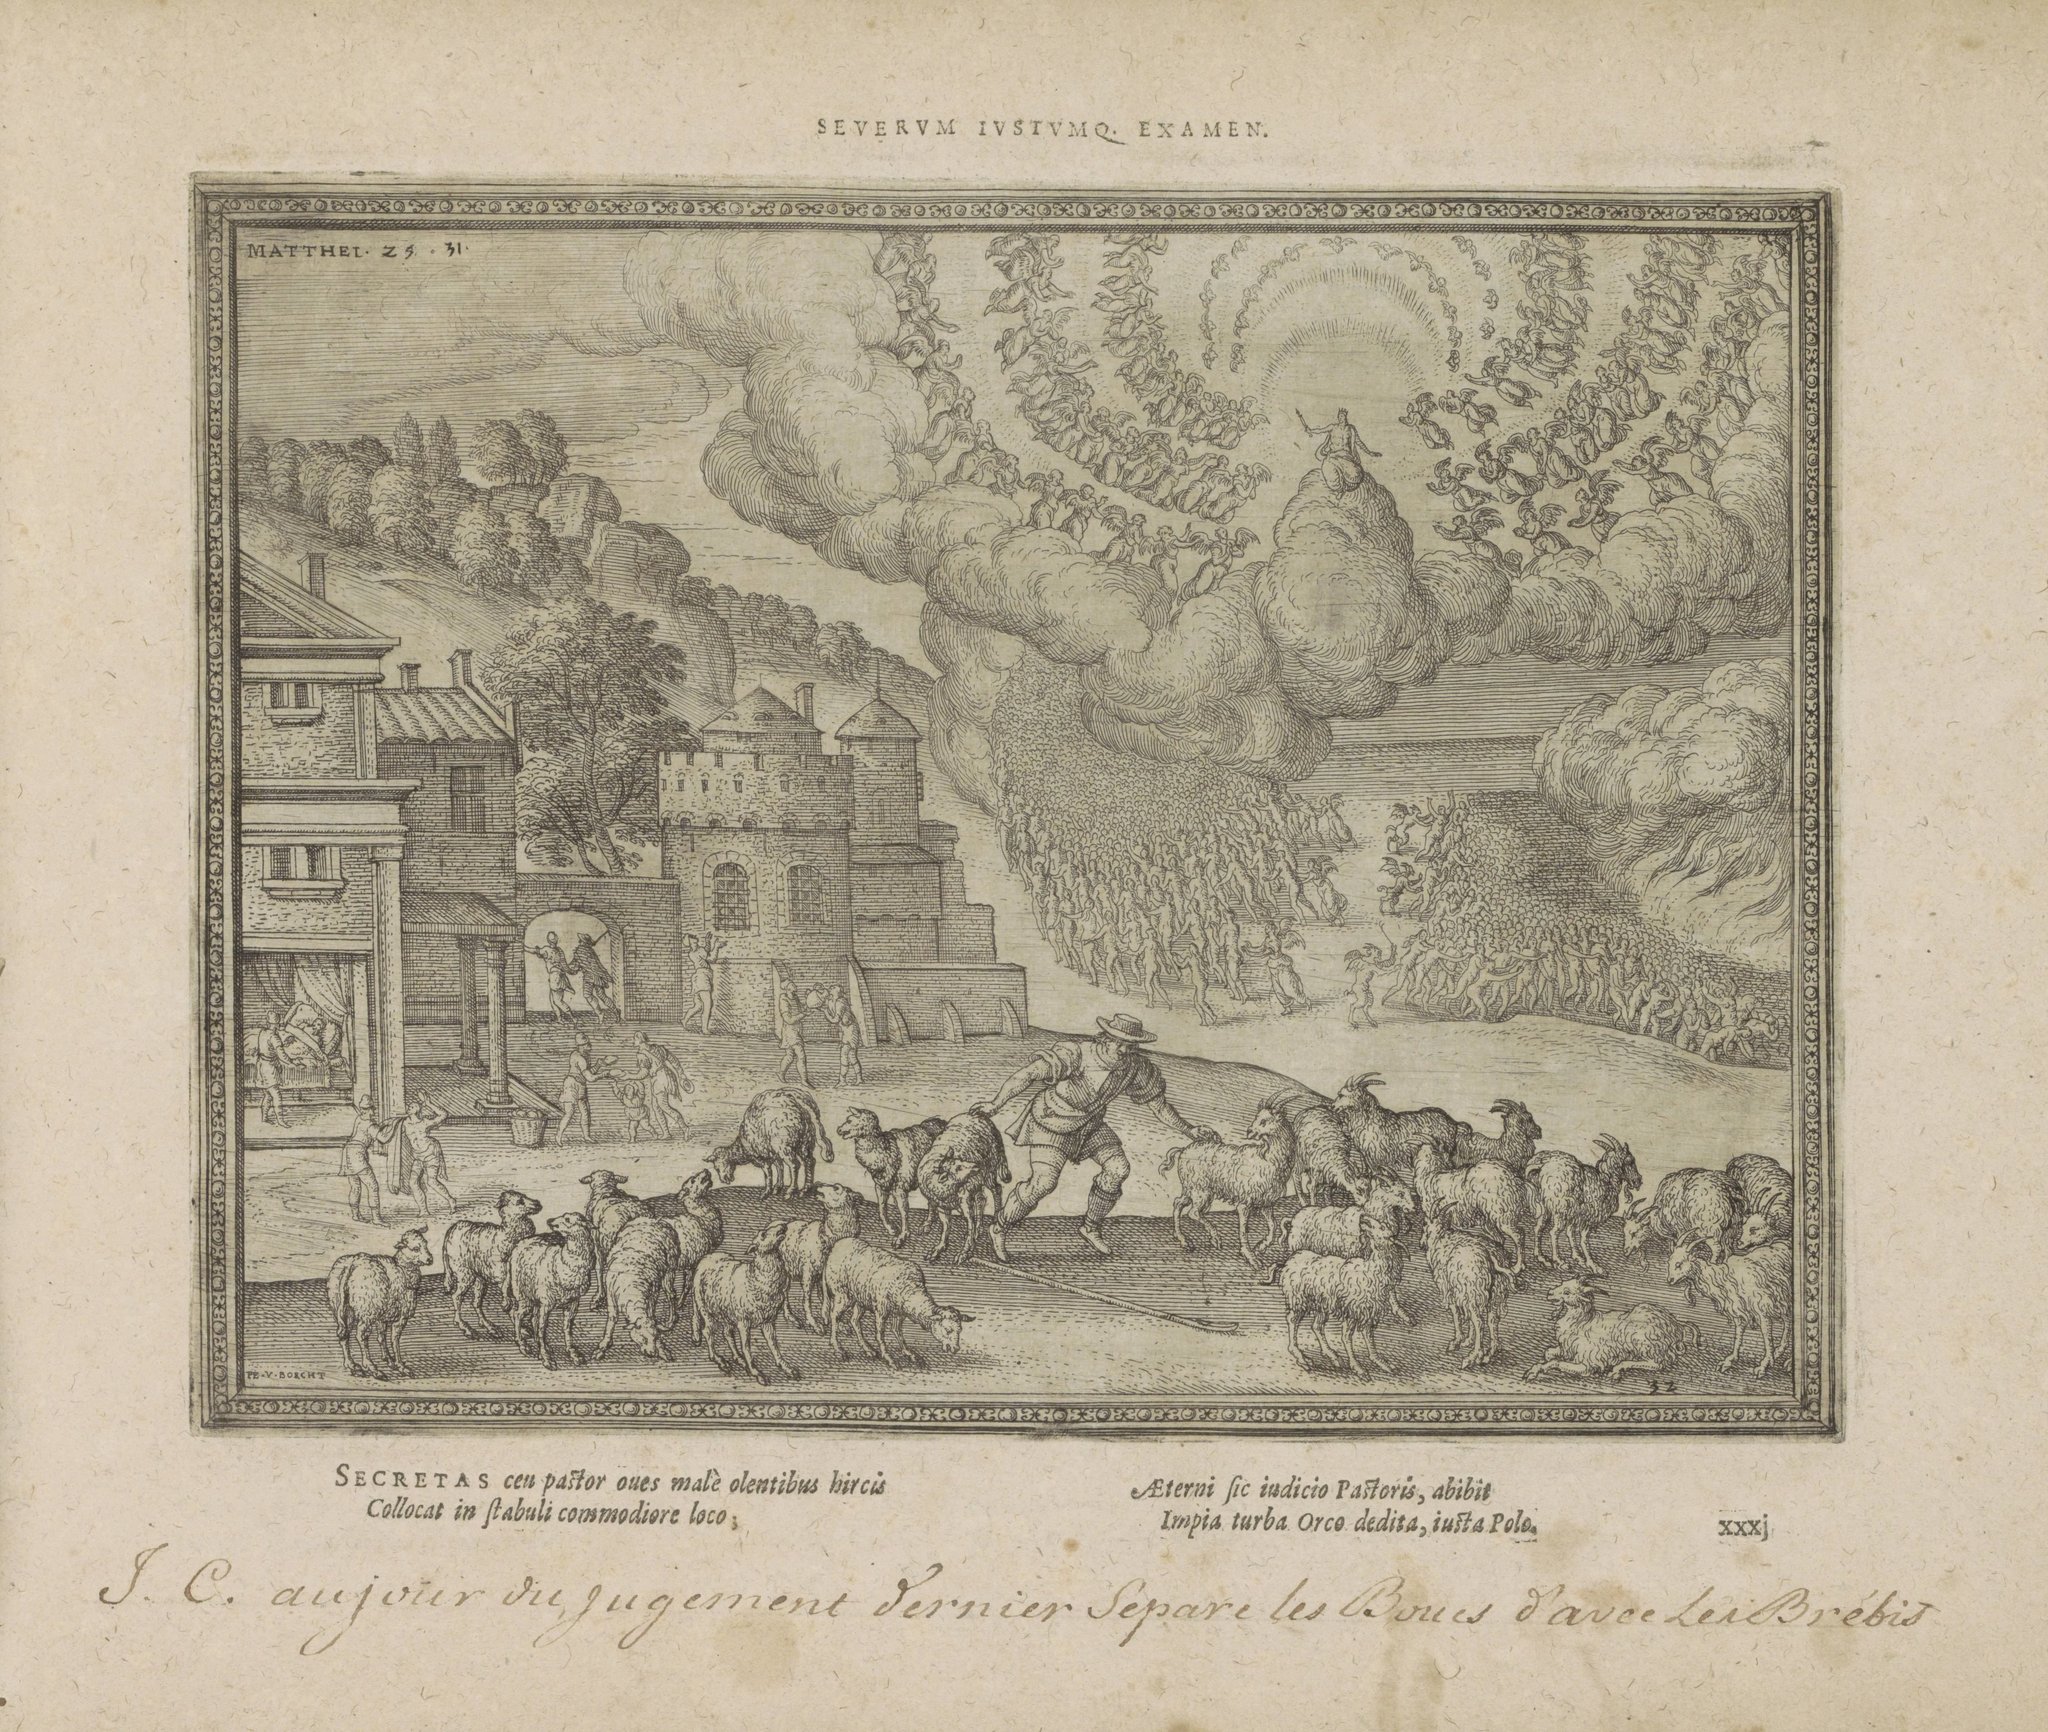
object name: print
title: Emblemata Novi Testamenti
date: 1582-1593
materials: paper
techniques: etching, letterpress printing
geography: antwerp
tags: 'as a shepherd (the son of man) separates the sheep from the goats' (matthew 25:32), representation of last judgement, with the archangel michael weighing the souls (or dividing the blessed and the damned)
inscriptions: inscription: ‘J.C. aujour du jugement dernier separe les boucs d'avec les brébis’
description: Een herder scheidt de schapen van de bokken. Links op de achtergrond enkele gebouwen met een poort. Christus troont op de wolken en velt het laatste oordeel. De doden worden door engelen naar de hemel geleid of naar de hel gevoerd (Mat. 25). Met een motto in het Latijn boven de voorstelling en een vierregelig onderschrift in het Latijn onder de prent. De prent maakt deel uit van een album.